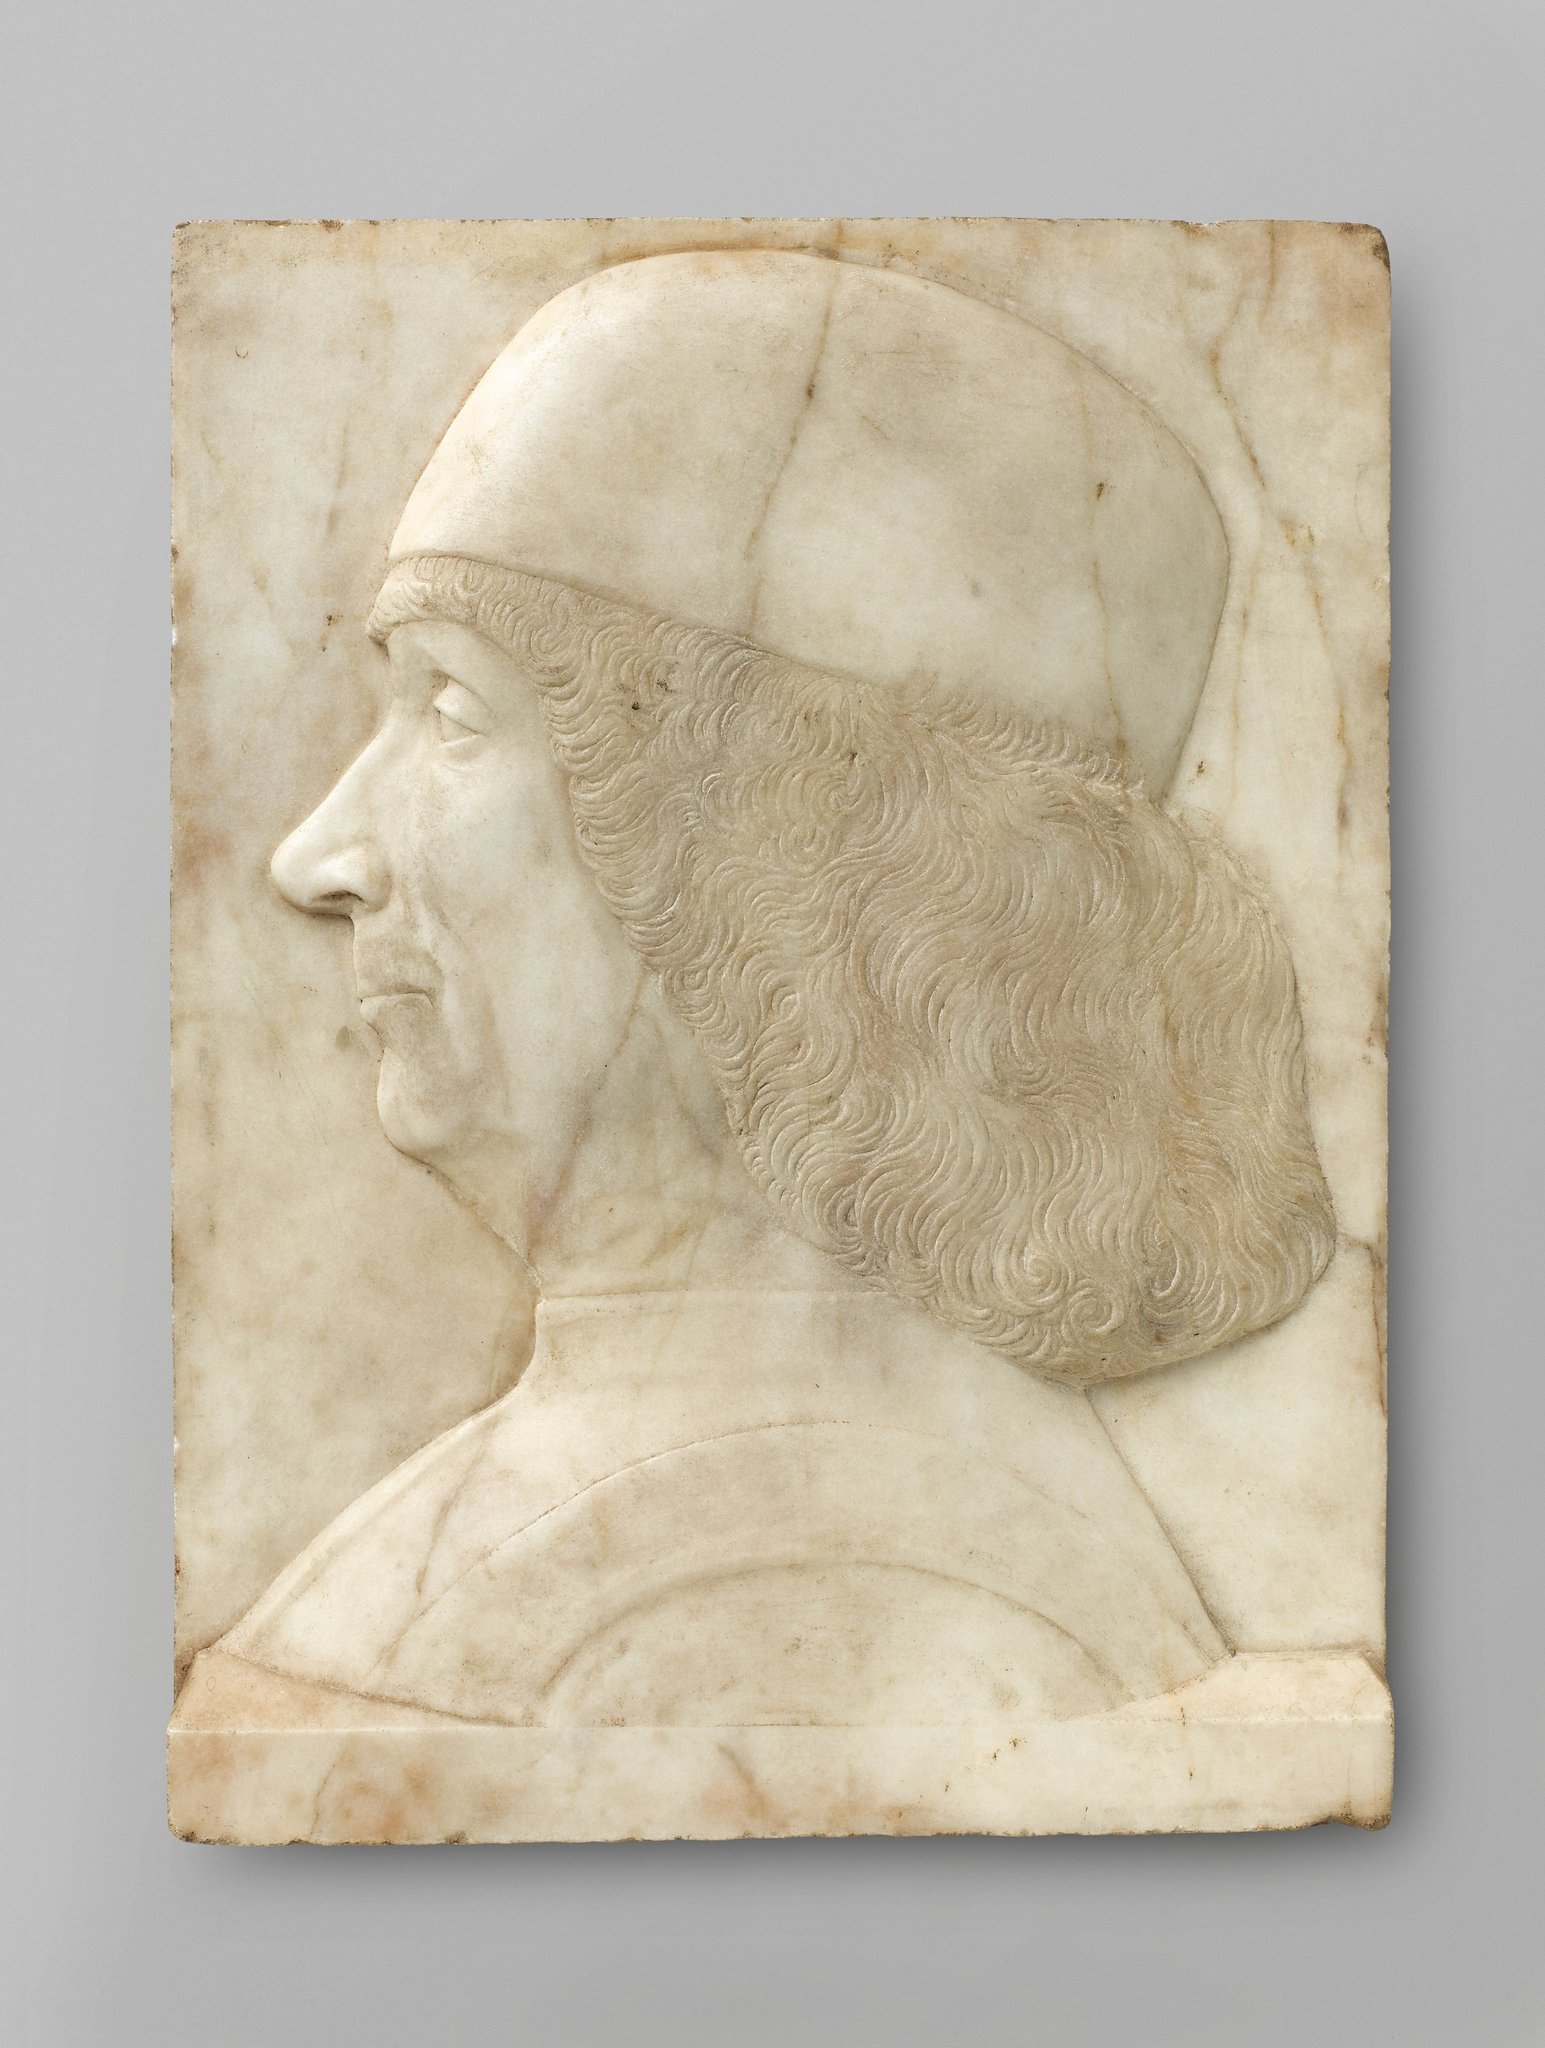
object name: sculpture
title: Portrait of Gentile Bellini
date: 1500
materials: marble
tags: venice, gentile bellini, historical persons (+ profile portrait)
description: Using a few sharply defined planes and no background, the sculptor effectively rendered the stark profile of this older man. The sitter is the Venetian artist Gentile Bellini. Even the precisely described locks of hair appear to be on a single plane. The sculptor used one of Bellini’s own sketches.